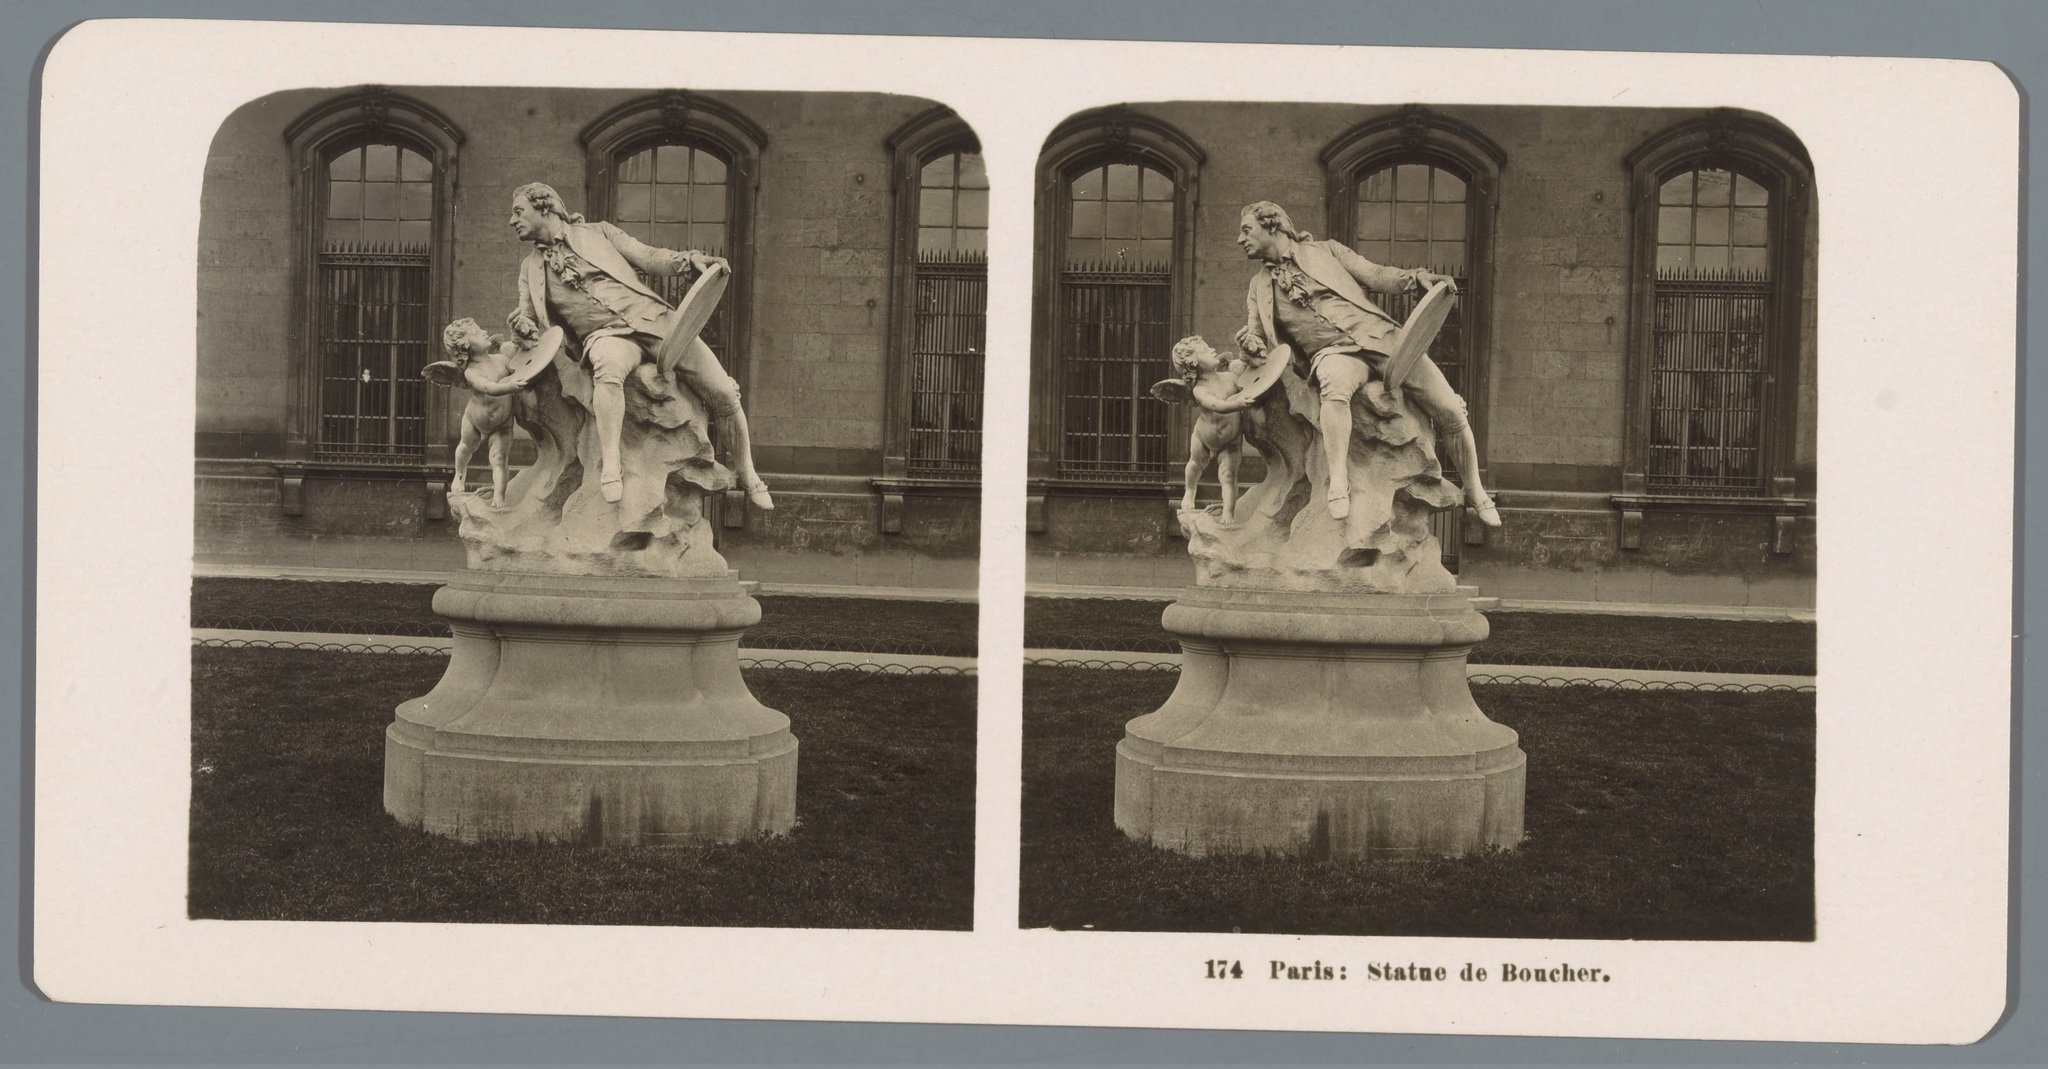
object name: stereograph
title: Paris: Statue de Boucher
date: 1904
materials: cardboard, photographic support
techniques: gelatin silver print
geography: paris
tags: portrait, self-portrait of painter, monument, statue, sculpture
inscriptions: number: ‘174’, inscription: ‘Neue Photographische Gesellschaft A.-G. Steglitz-Berlin 1904.’